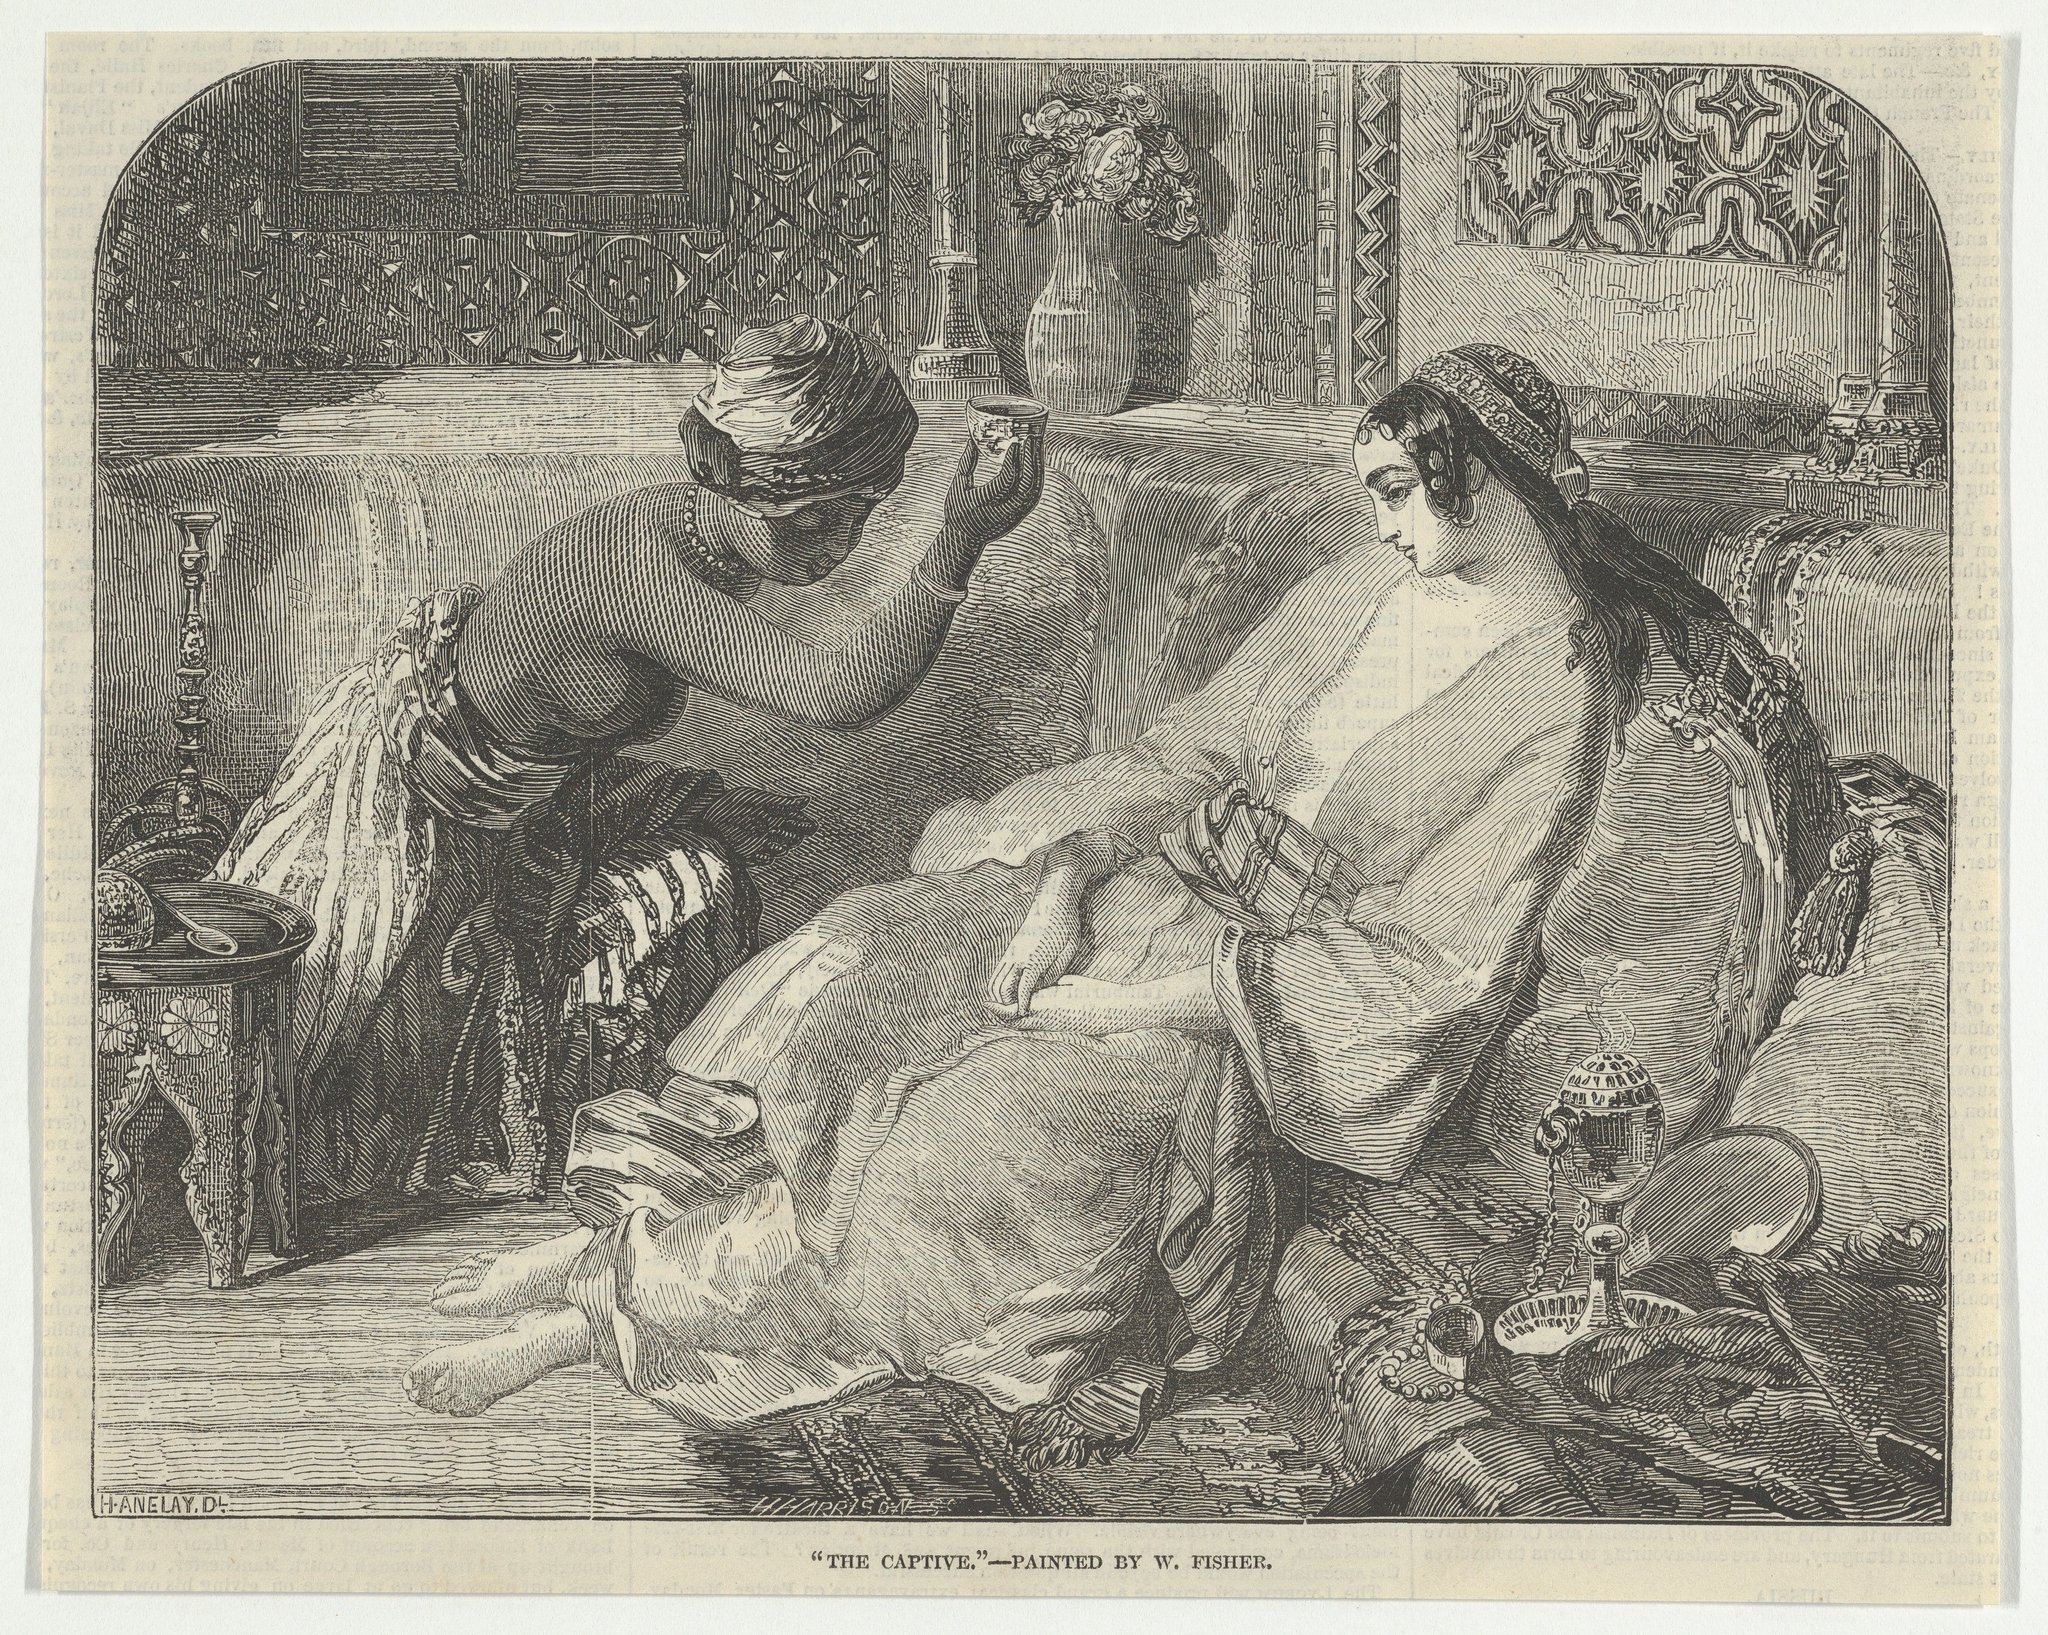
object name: print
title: The Captive, from "Illustrated London News"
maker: h. harrison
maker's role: engraver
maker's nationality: british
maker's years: 1848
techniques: engraving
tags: women